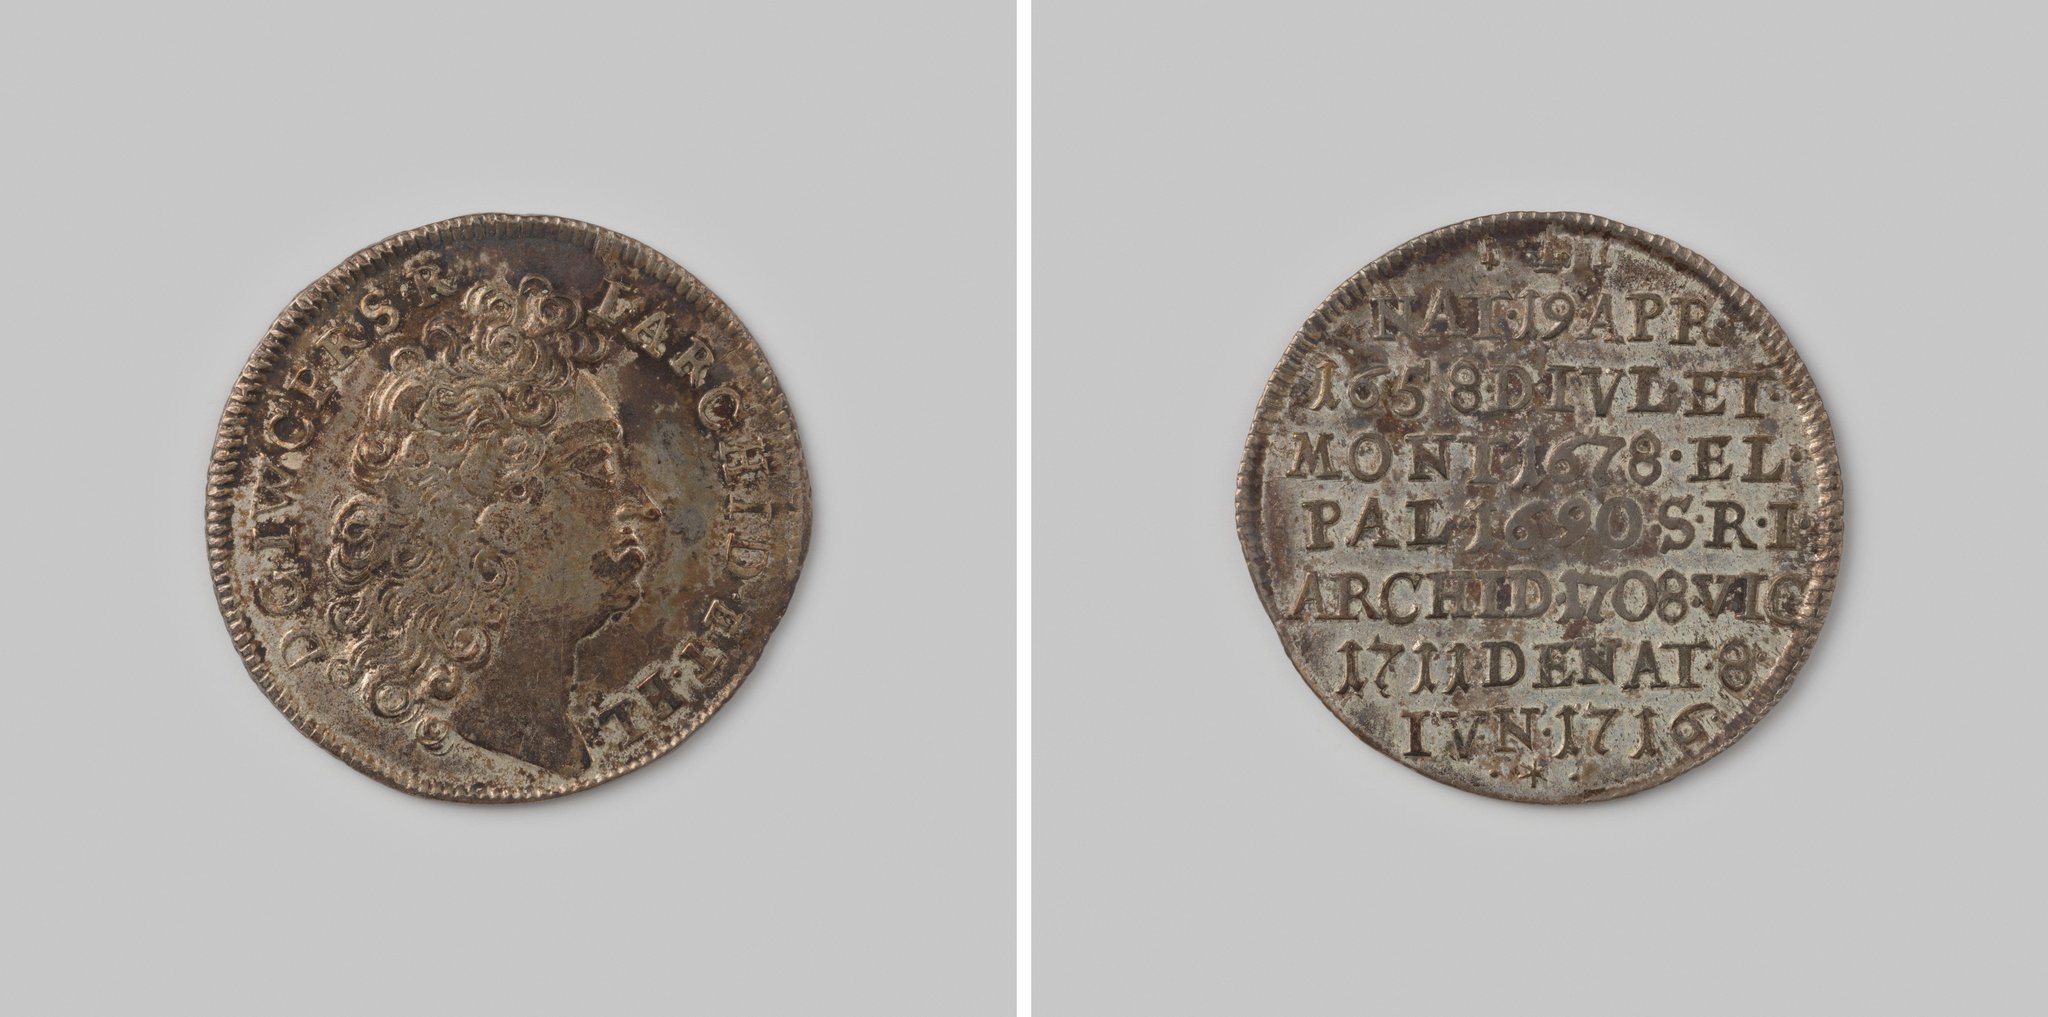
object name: coin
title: Churpfalz, Johann Wilhelm von Neuburg, 1/8 Sterbethaler,1716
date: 1716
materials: silver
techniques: striking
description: Zilveren munt. Voorzijde: portret van de vorst naar rechts. Keerzijde: opschrift van zeven regels. Jaartal in laatste regel. Kabelrand. Geslagen ter gelegenheid van het overlijden van de vorst.